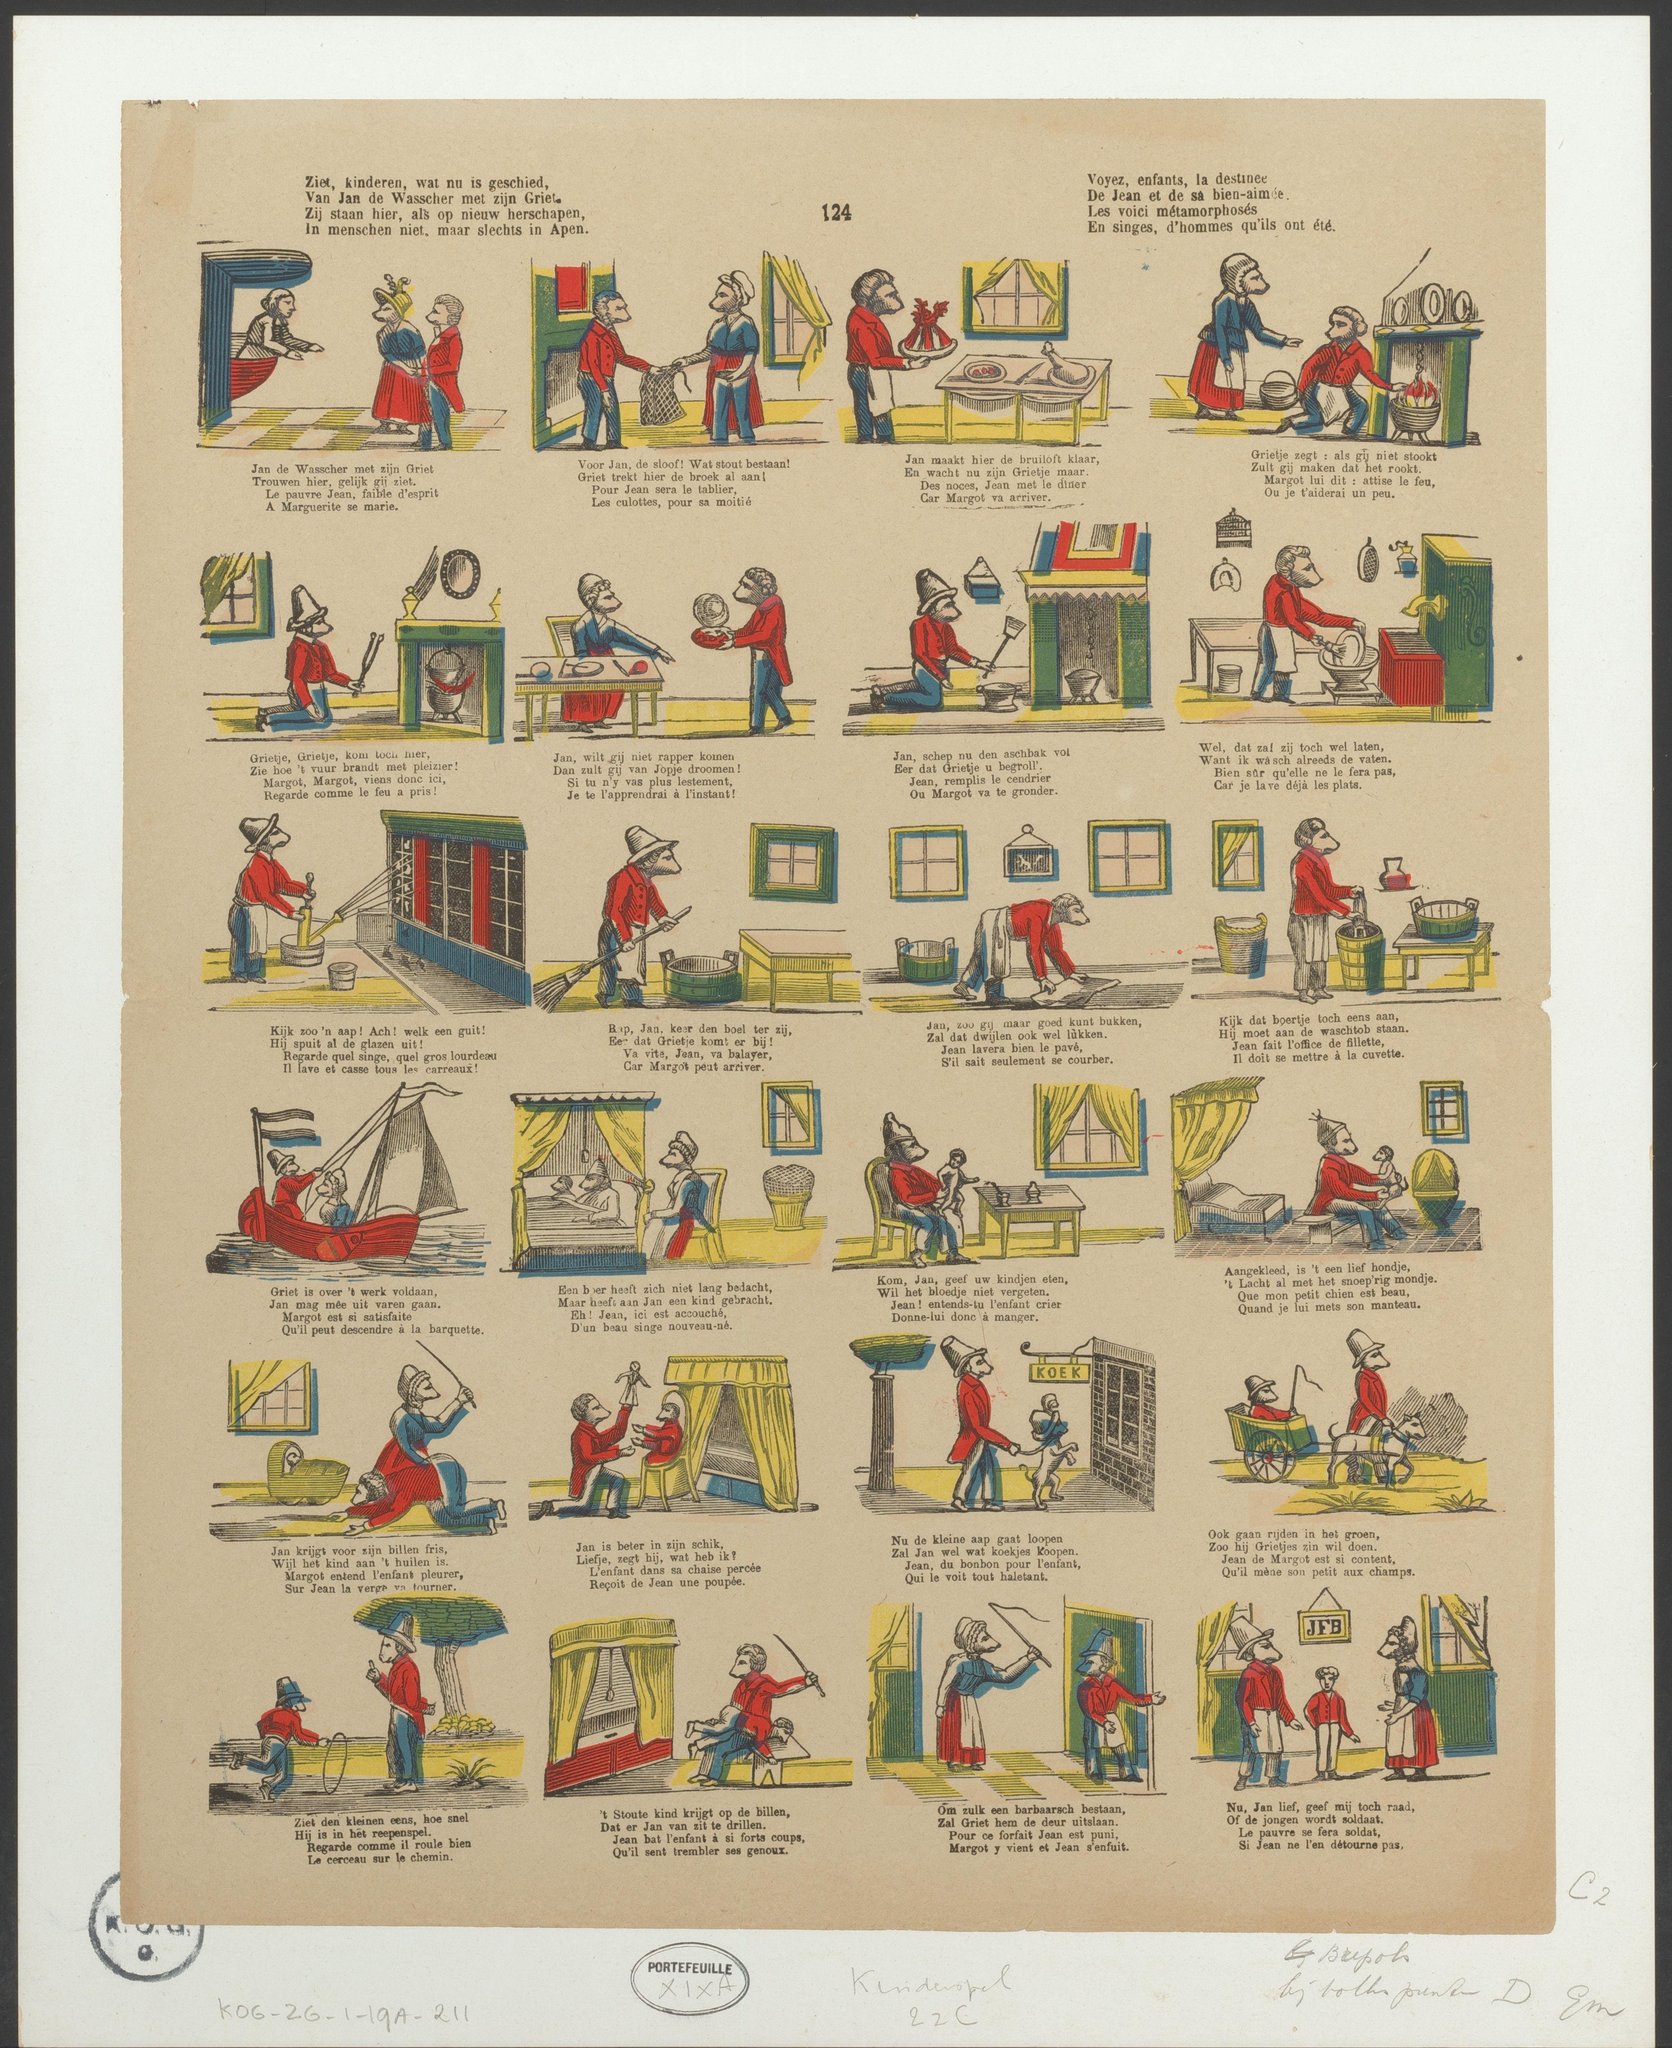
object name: print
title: Leven van Jan de Wasser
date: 1800-1833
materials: paper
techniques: hand coloring, letterpress printing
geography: turnhout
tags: hen-pecked husband, 'betty', 'molly' (man who engages in women's work), monkeys, apes, animals acting as human beings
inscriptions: collector's mark: Lugt 1641, stamp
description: Blad met 24 voorstellingen uit het leven van Jan de Wasser, een man die van zijn vrouw Griet, die de broek aan heeft, al het huishoudelijk werk moet doen. Uitgebeeld met apen in plaats van mensen. Onder elke voorstelling een tweeregelig vers in het Nederlands en in het Frans. Genummerd midden boven: 124. Onderwerpsrubrieken binnen de Atlas Zeden en Gewoonten: Zeden en Gewoonten in Engeren Zin, Des menschen beging, midden en einde, Kinderleven – Kinderspel en Kinderprenten.